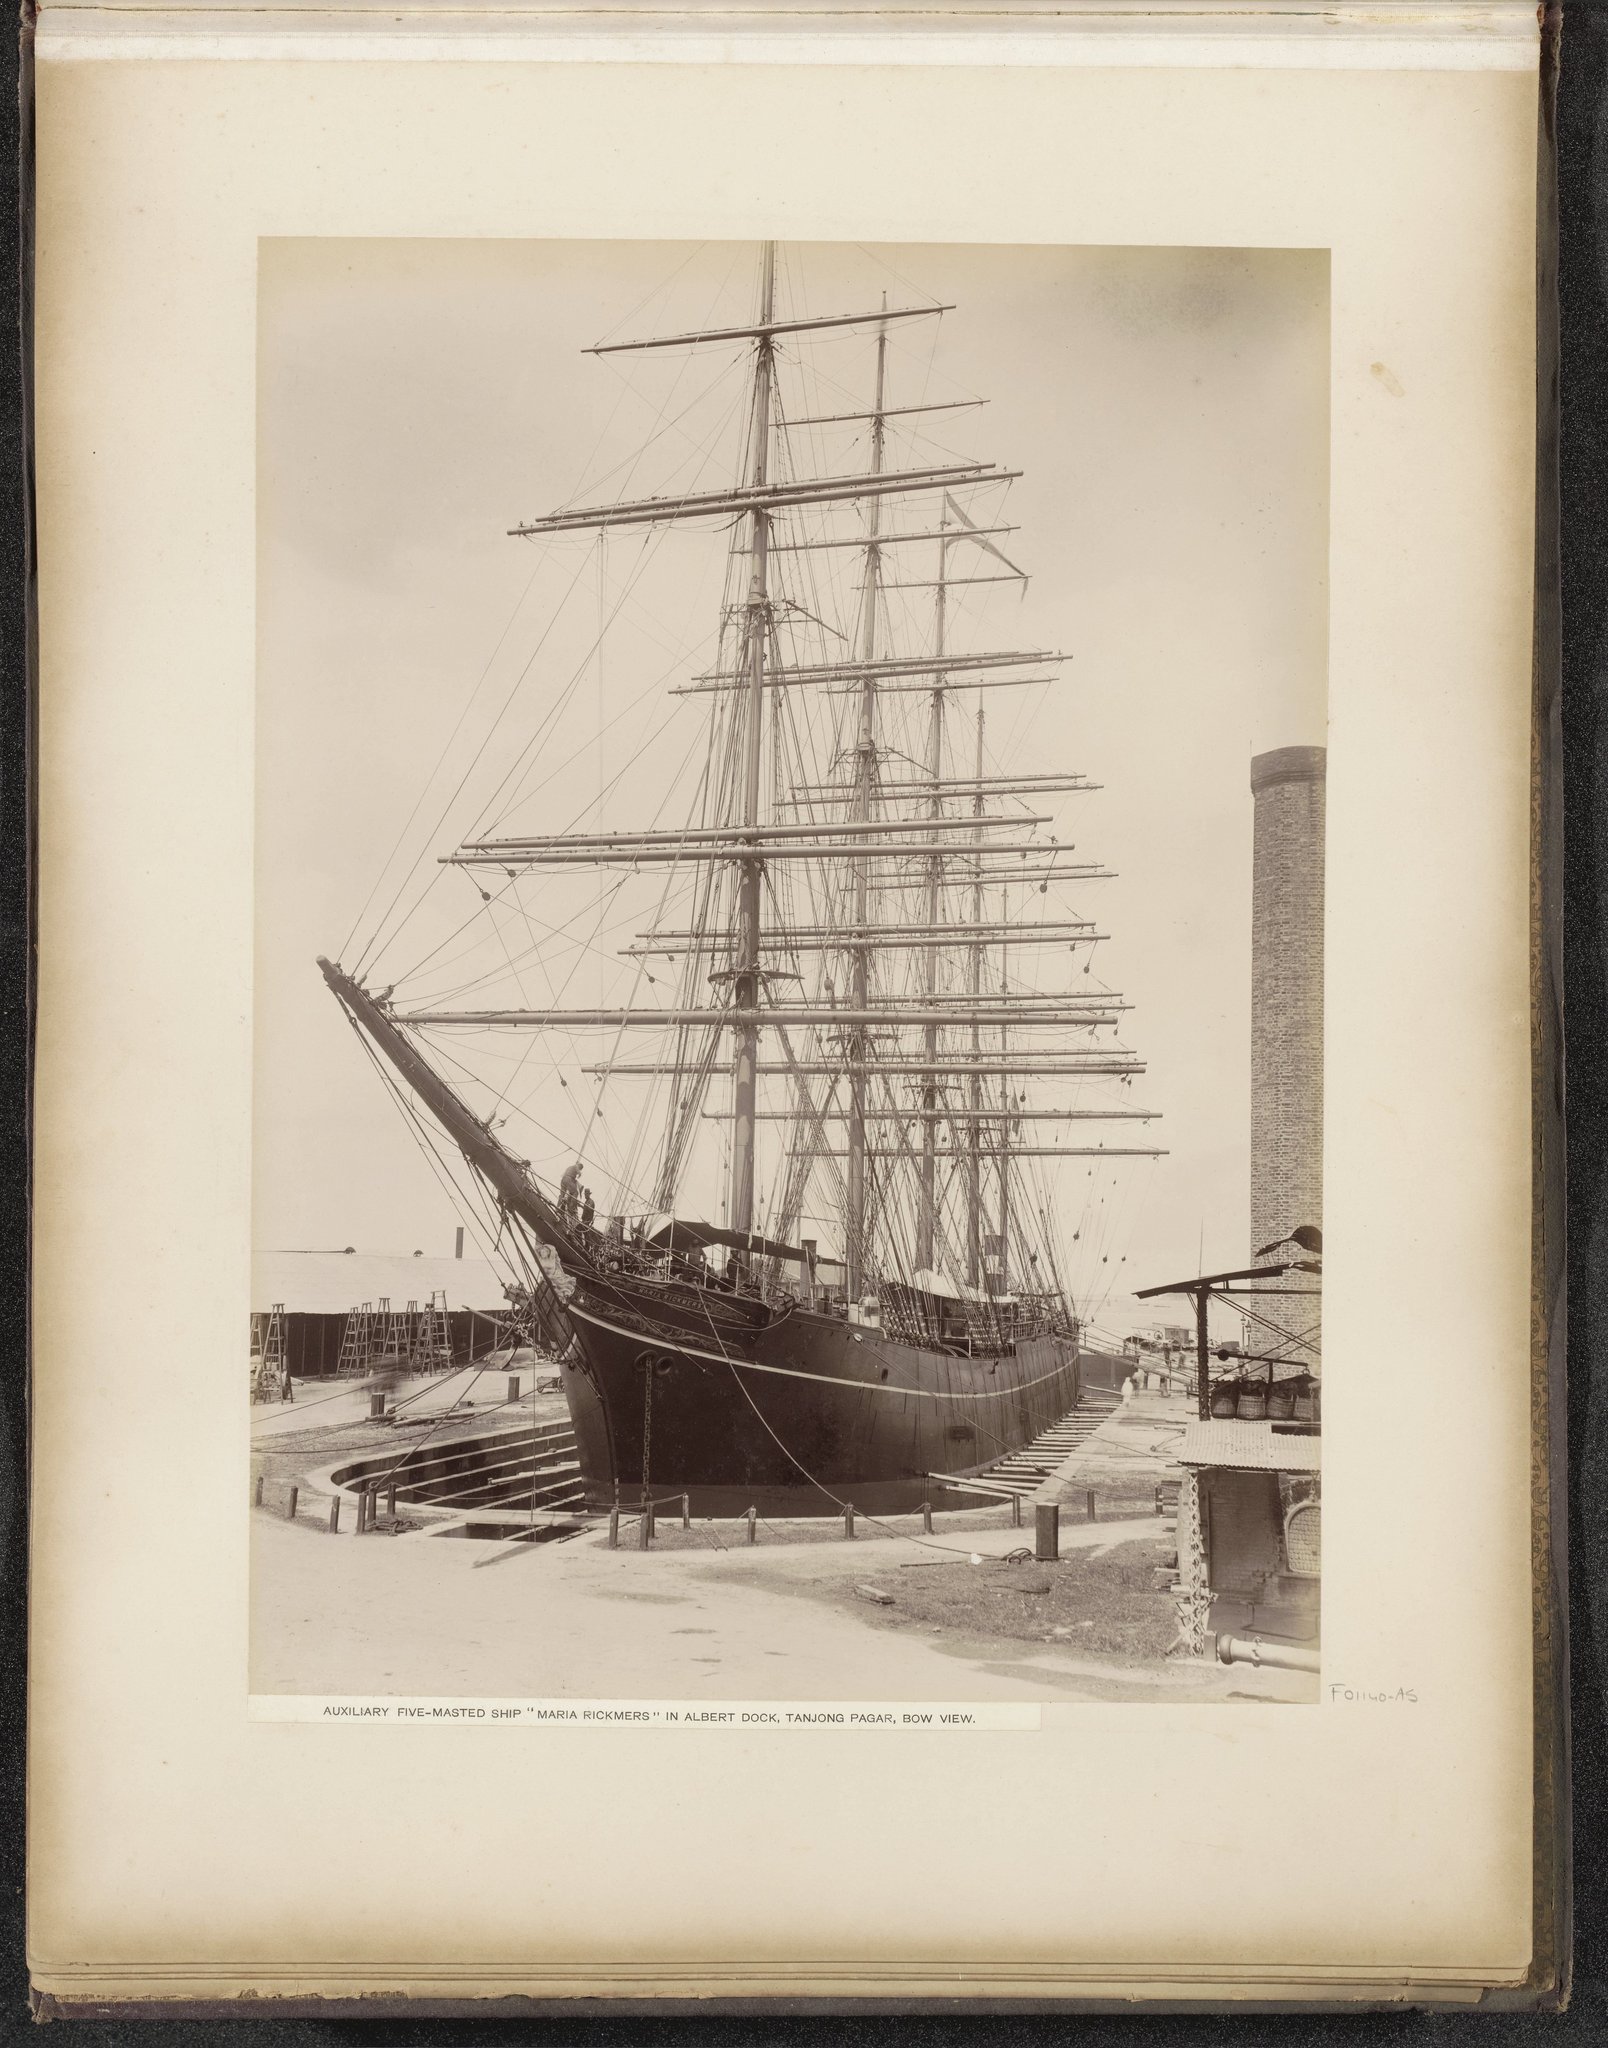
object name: photograph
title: Auxiliary five-masted ship "Maria Rickmers" in Albert Dock, Tanjong Pagar, bow view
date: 1890-1905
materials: photographic support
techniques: albumen print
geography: singapore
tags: sailing-ship, sailing-boat, parts of ship's exterior: bow, pier, quay, wharf, shipyard, shipdock, parts of ship's exterior: mast, shipbuilding industry, singapore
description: Onderdeel van Fotoalbum van de Tanjong Pagar Dock Co. Ltd. in Singapore.